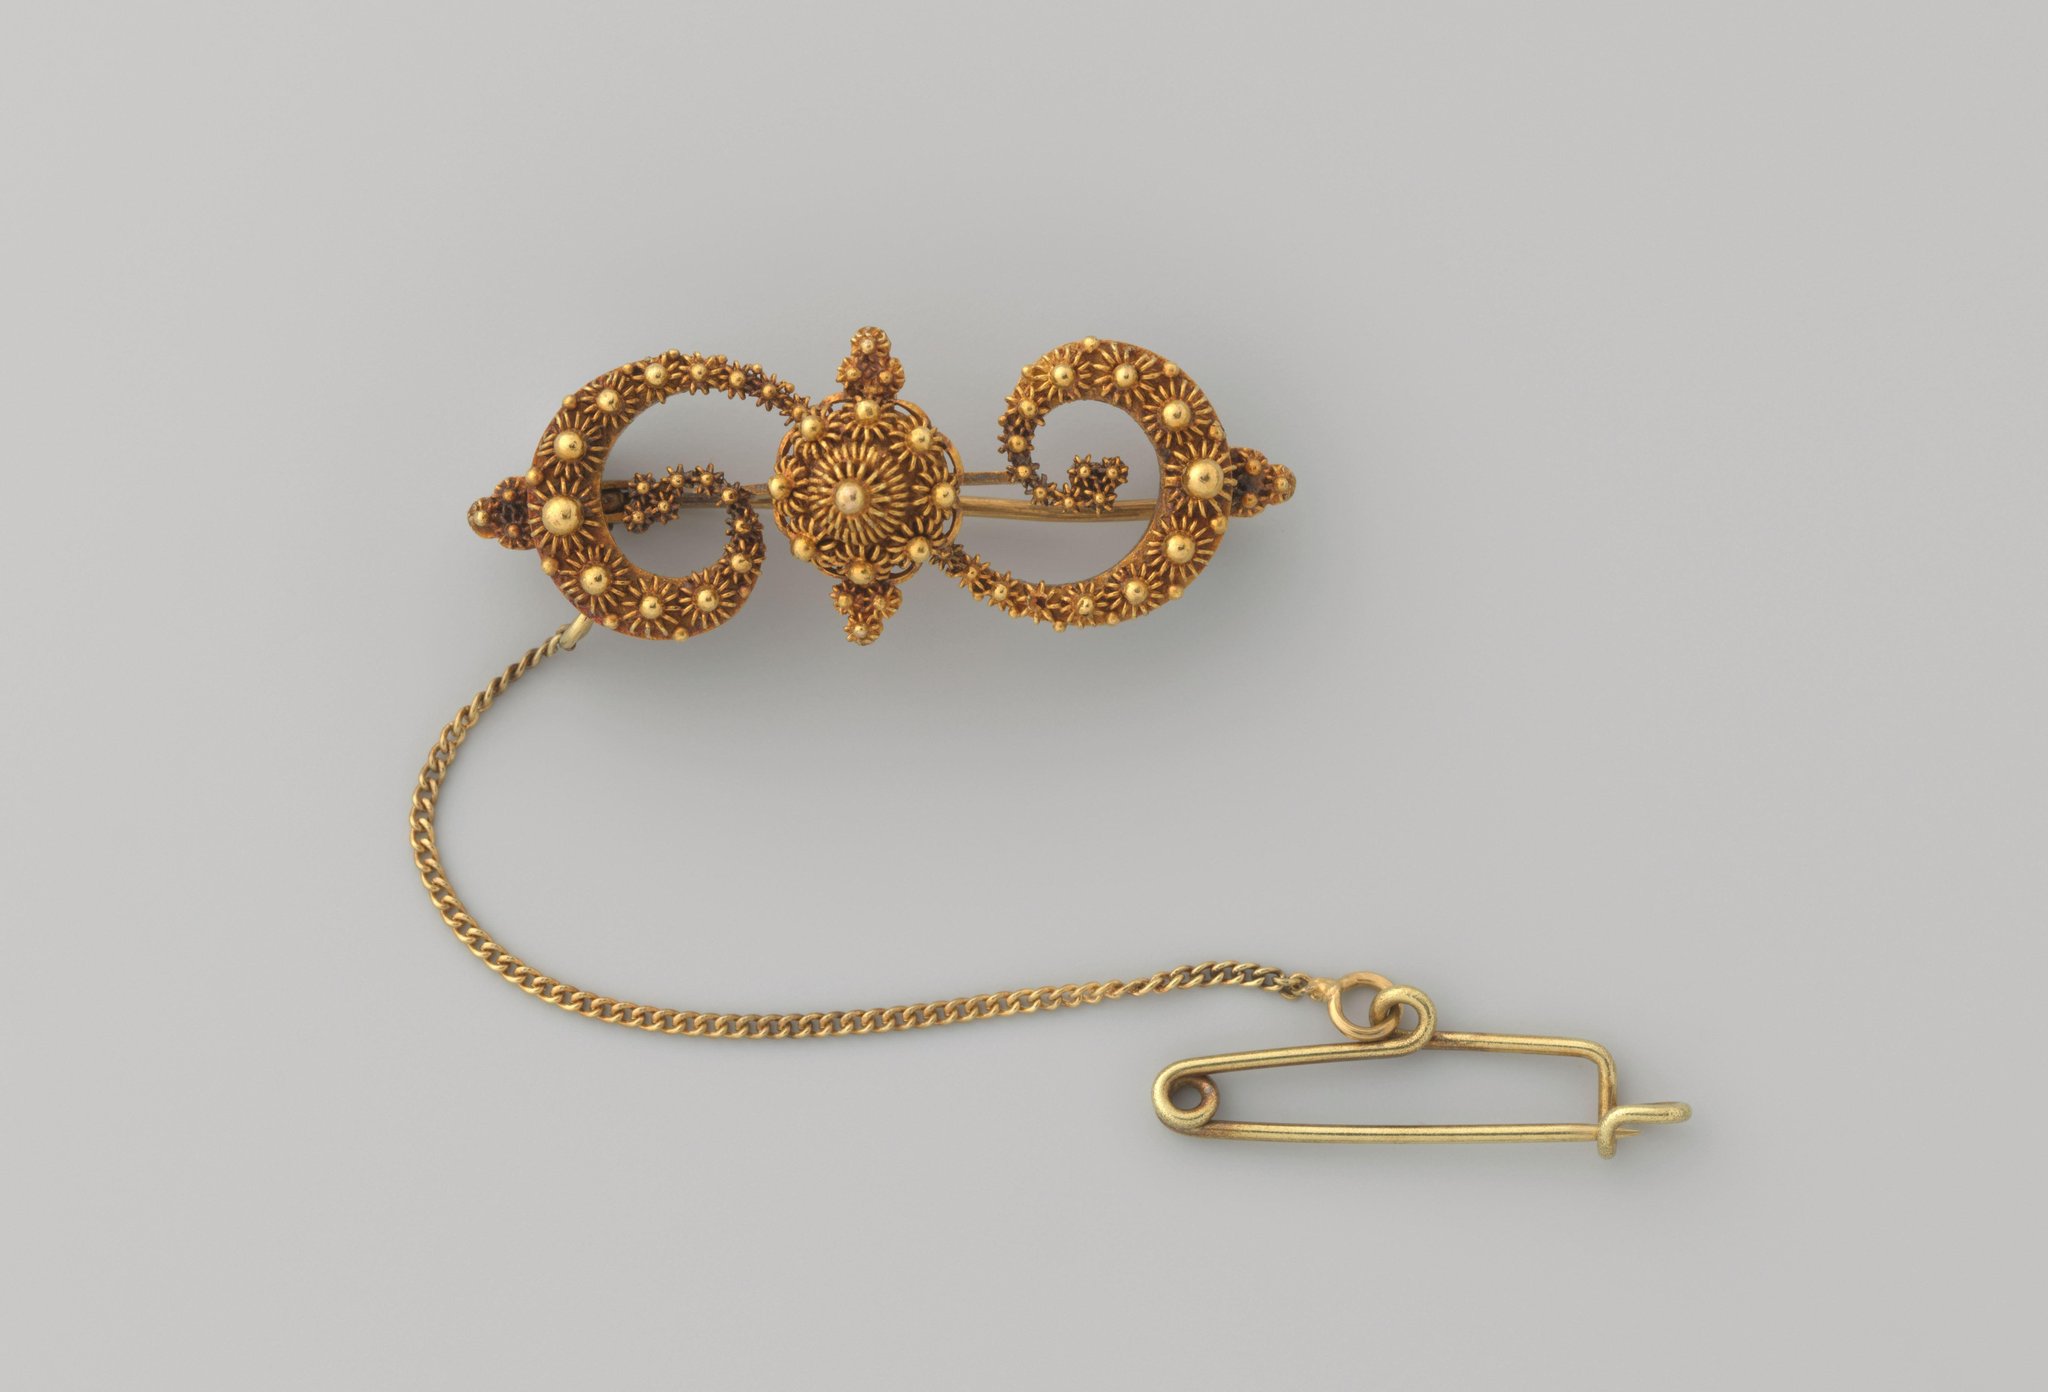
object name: sierspeld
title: S-vormige speld van goud bezet met spinnetjes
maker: Anonymous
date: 1930-1940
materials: gold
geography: netherlands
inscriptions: maker's mark: ‘PA’, alloy mark: ‘(oud) eikenblad’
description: S-vormige speld van goud bezet met spinnetjes voorzien van haaksluiting met veiligheidsketting.